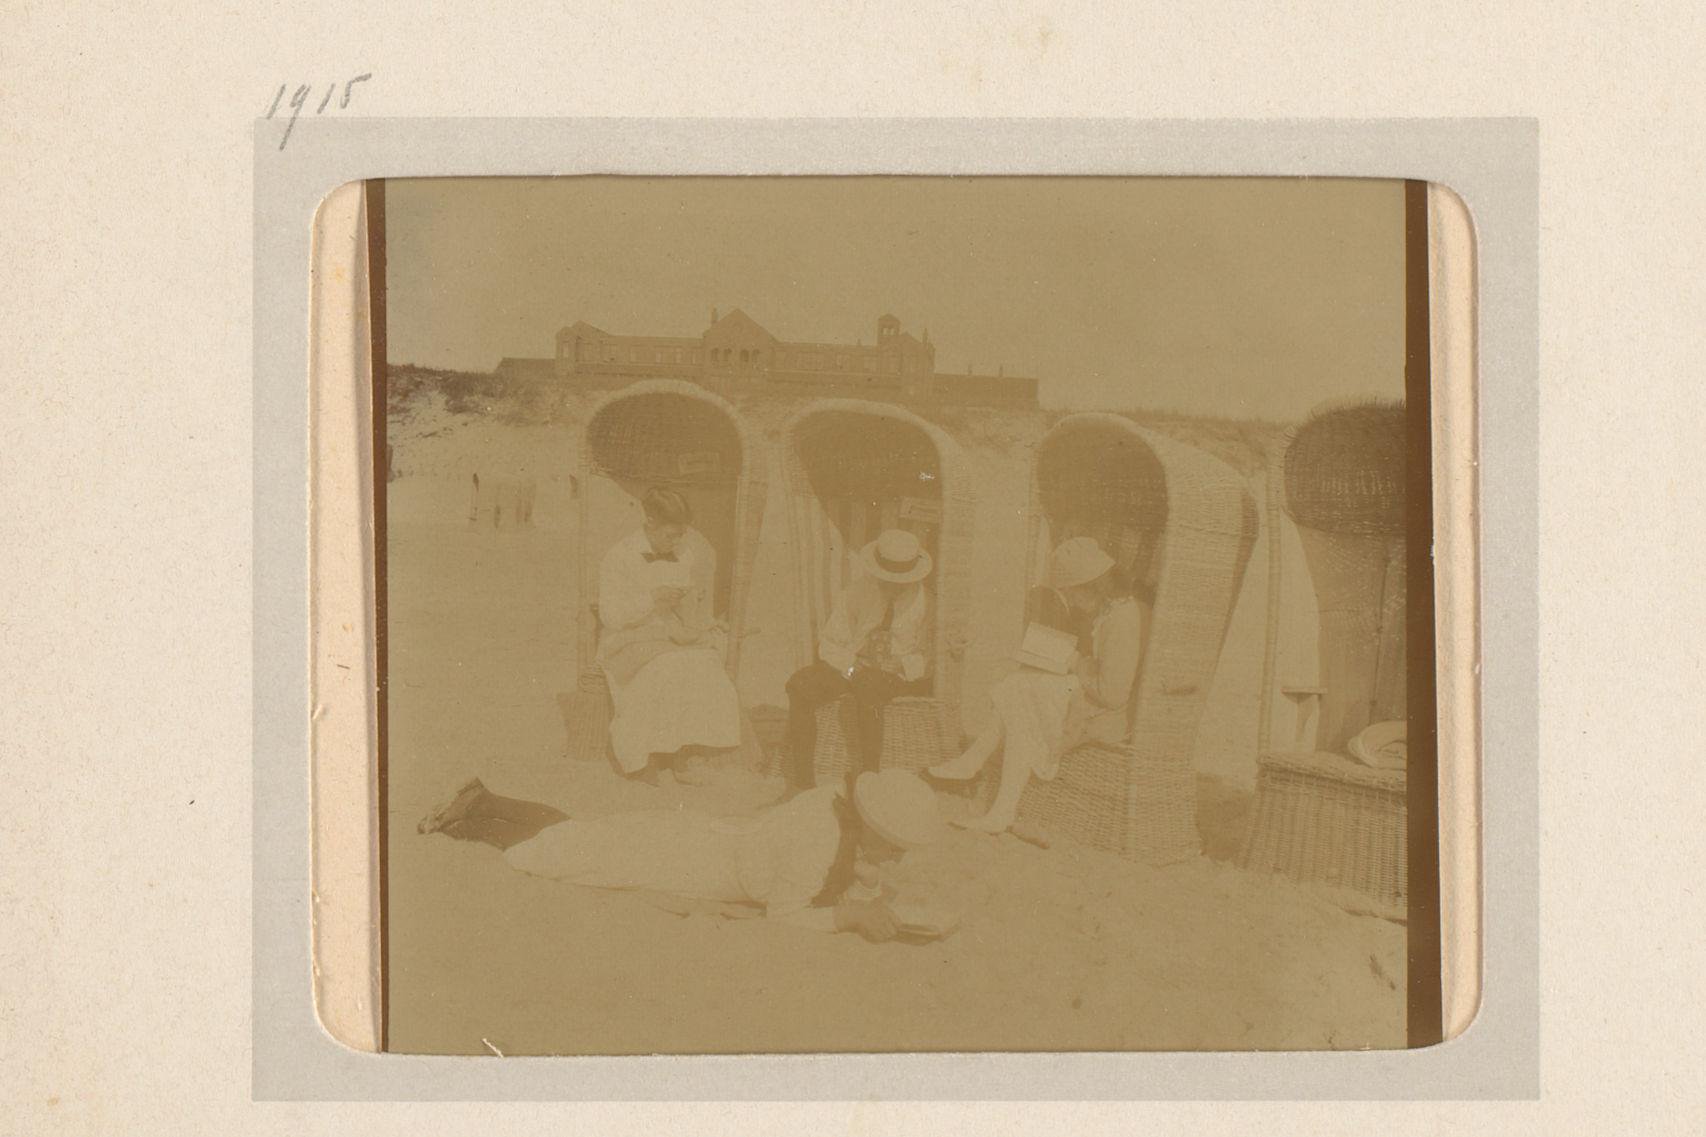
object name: album leaf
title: Lezend gezelschap in strandstoelen op het strand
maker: liesbeth overhoff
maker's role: fotograaf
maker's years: 1895-1969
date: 1915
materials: paper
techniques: gelatin silver print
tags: beach (as place of recreation), reading, historical persons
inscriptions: inscription: ‘1915’